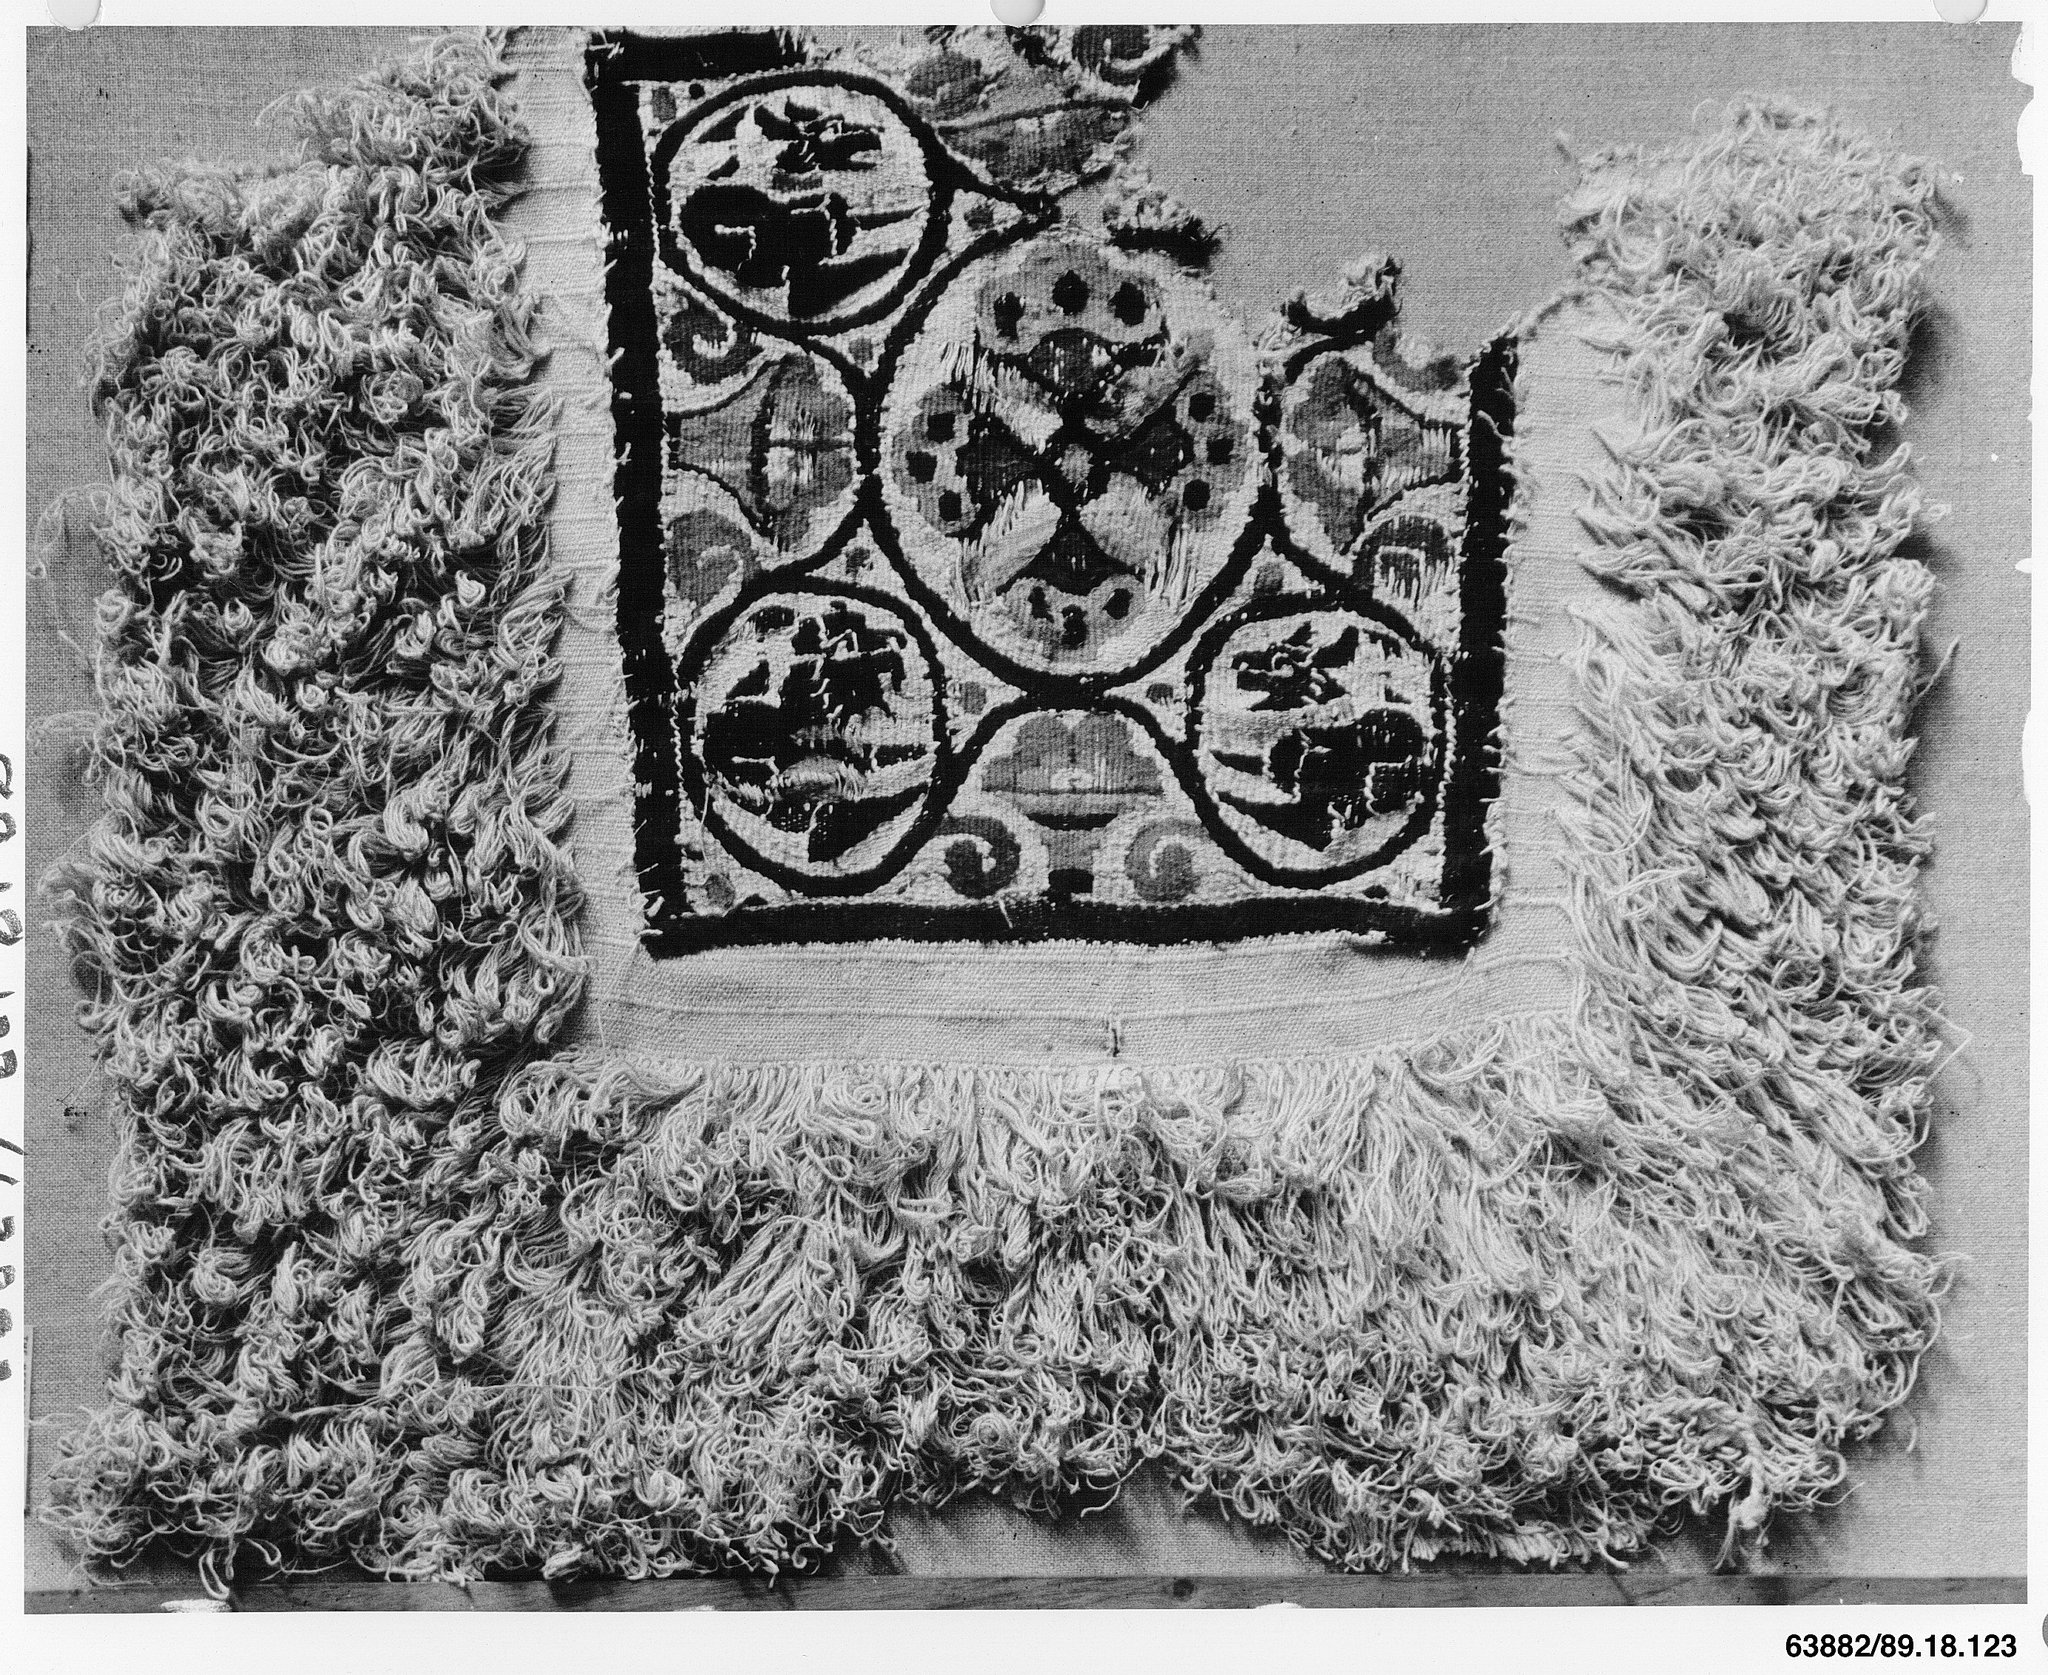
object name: textile fragment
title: Fragment of a Cover or Blanket with Ornamental Square Featuring Flowers and Animals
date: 401-600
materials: linen, wool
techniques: weave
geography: egypt